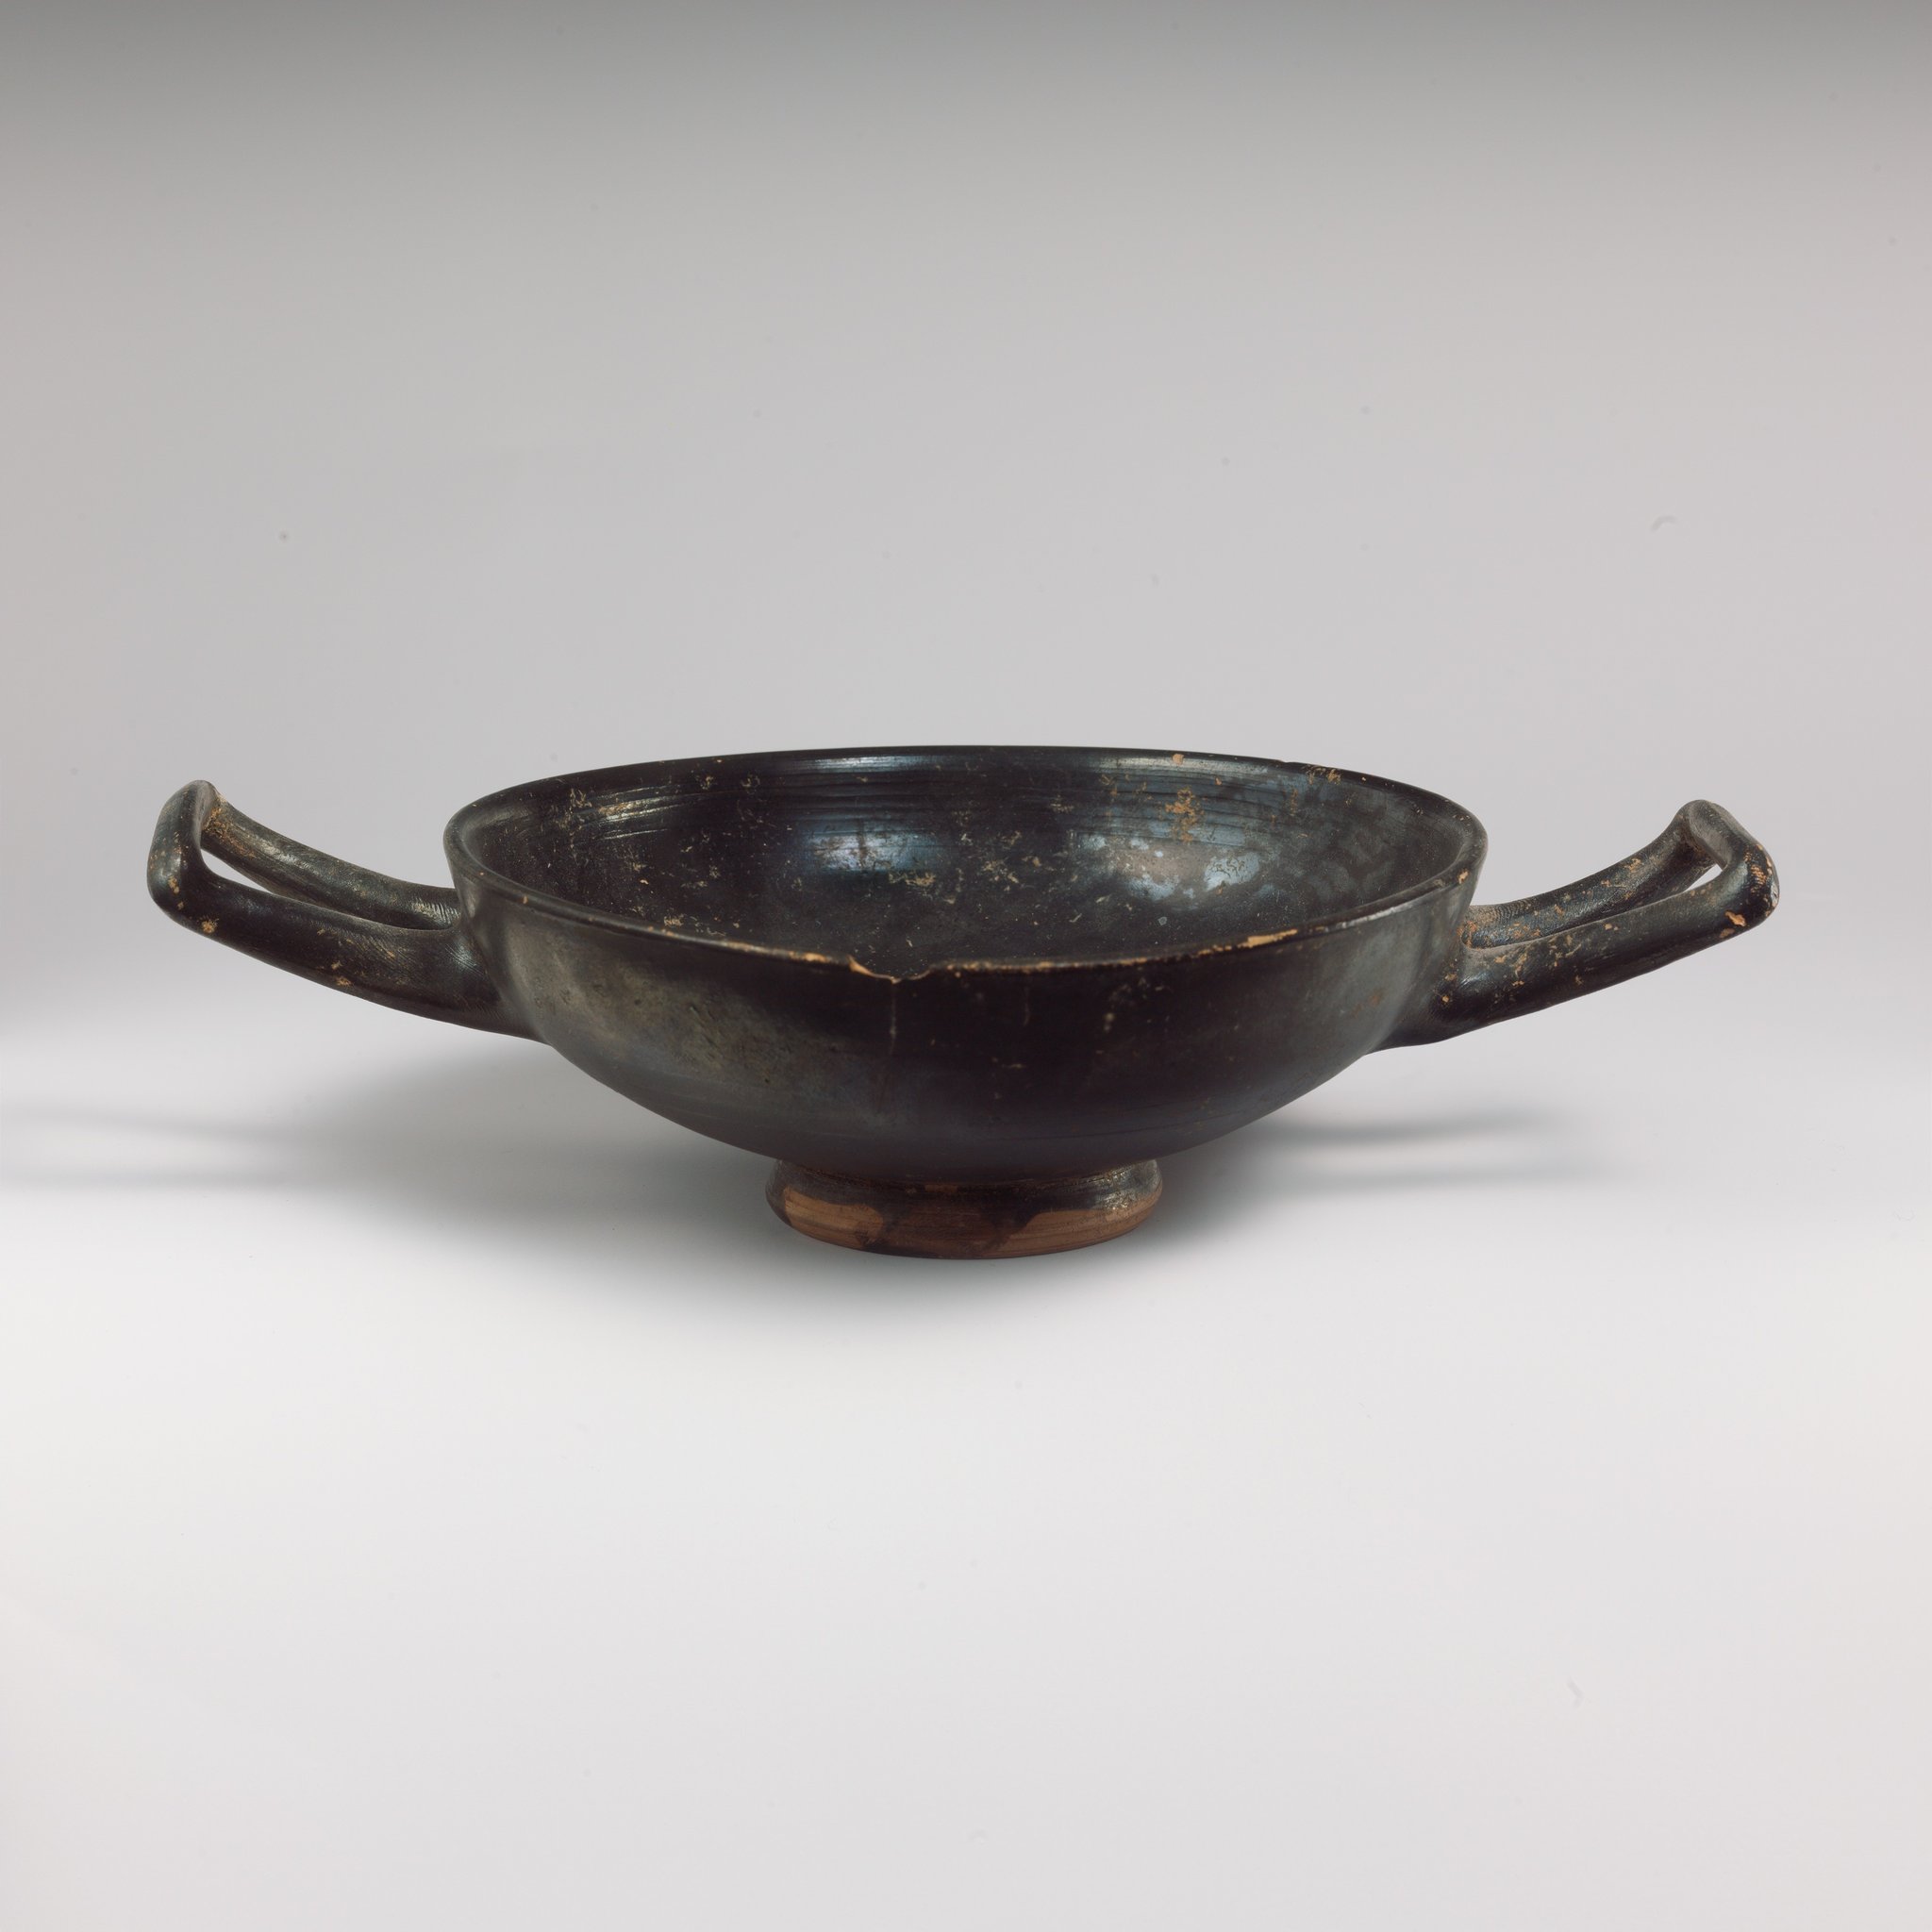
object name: kylix, stemless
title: Terracotta stemless kylix (drinking cup)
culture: greek or south italian or campanian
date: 400-301 BCE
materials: terracotta